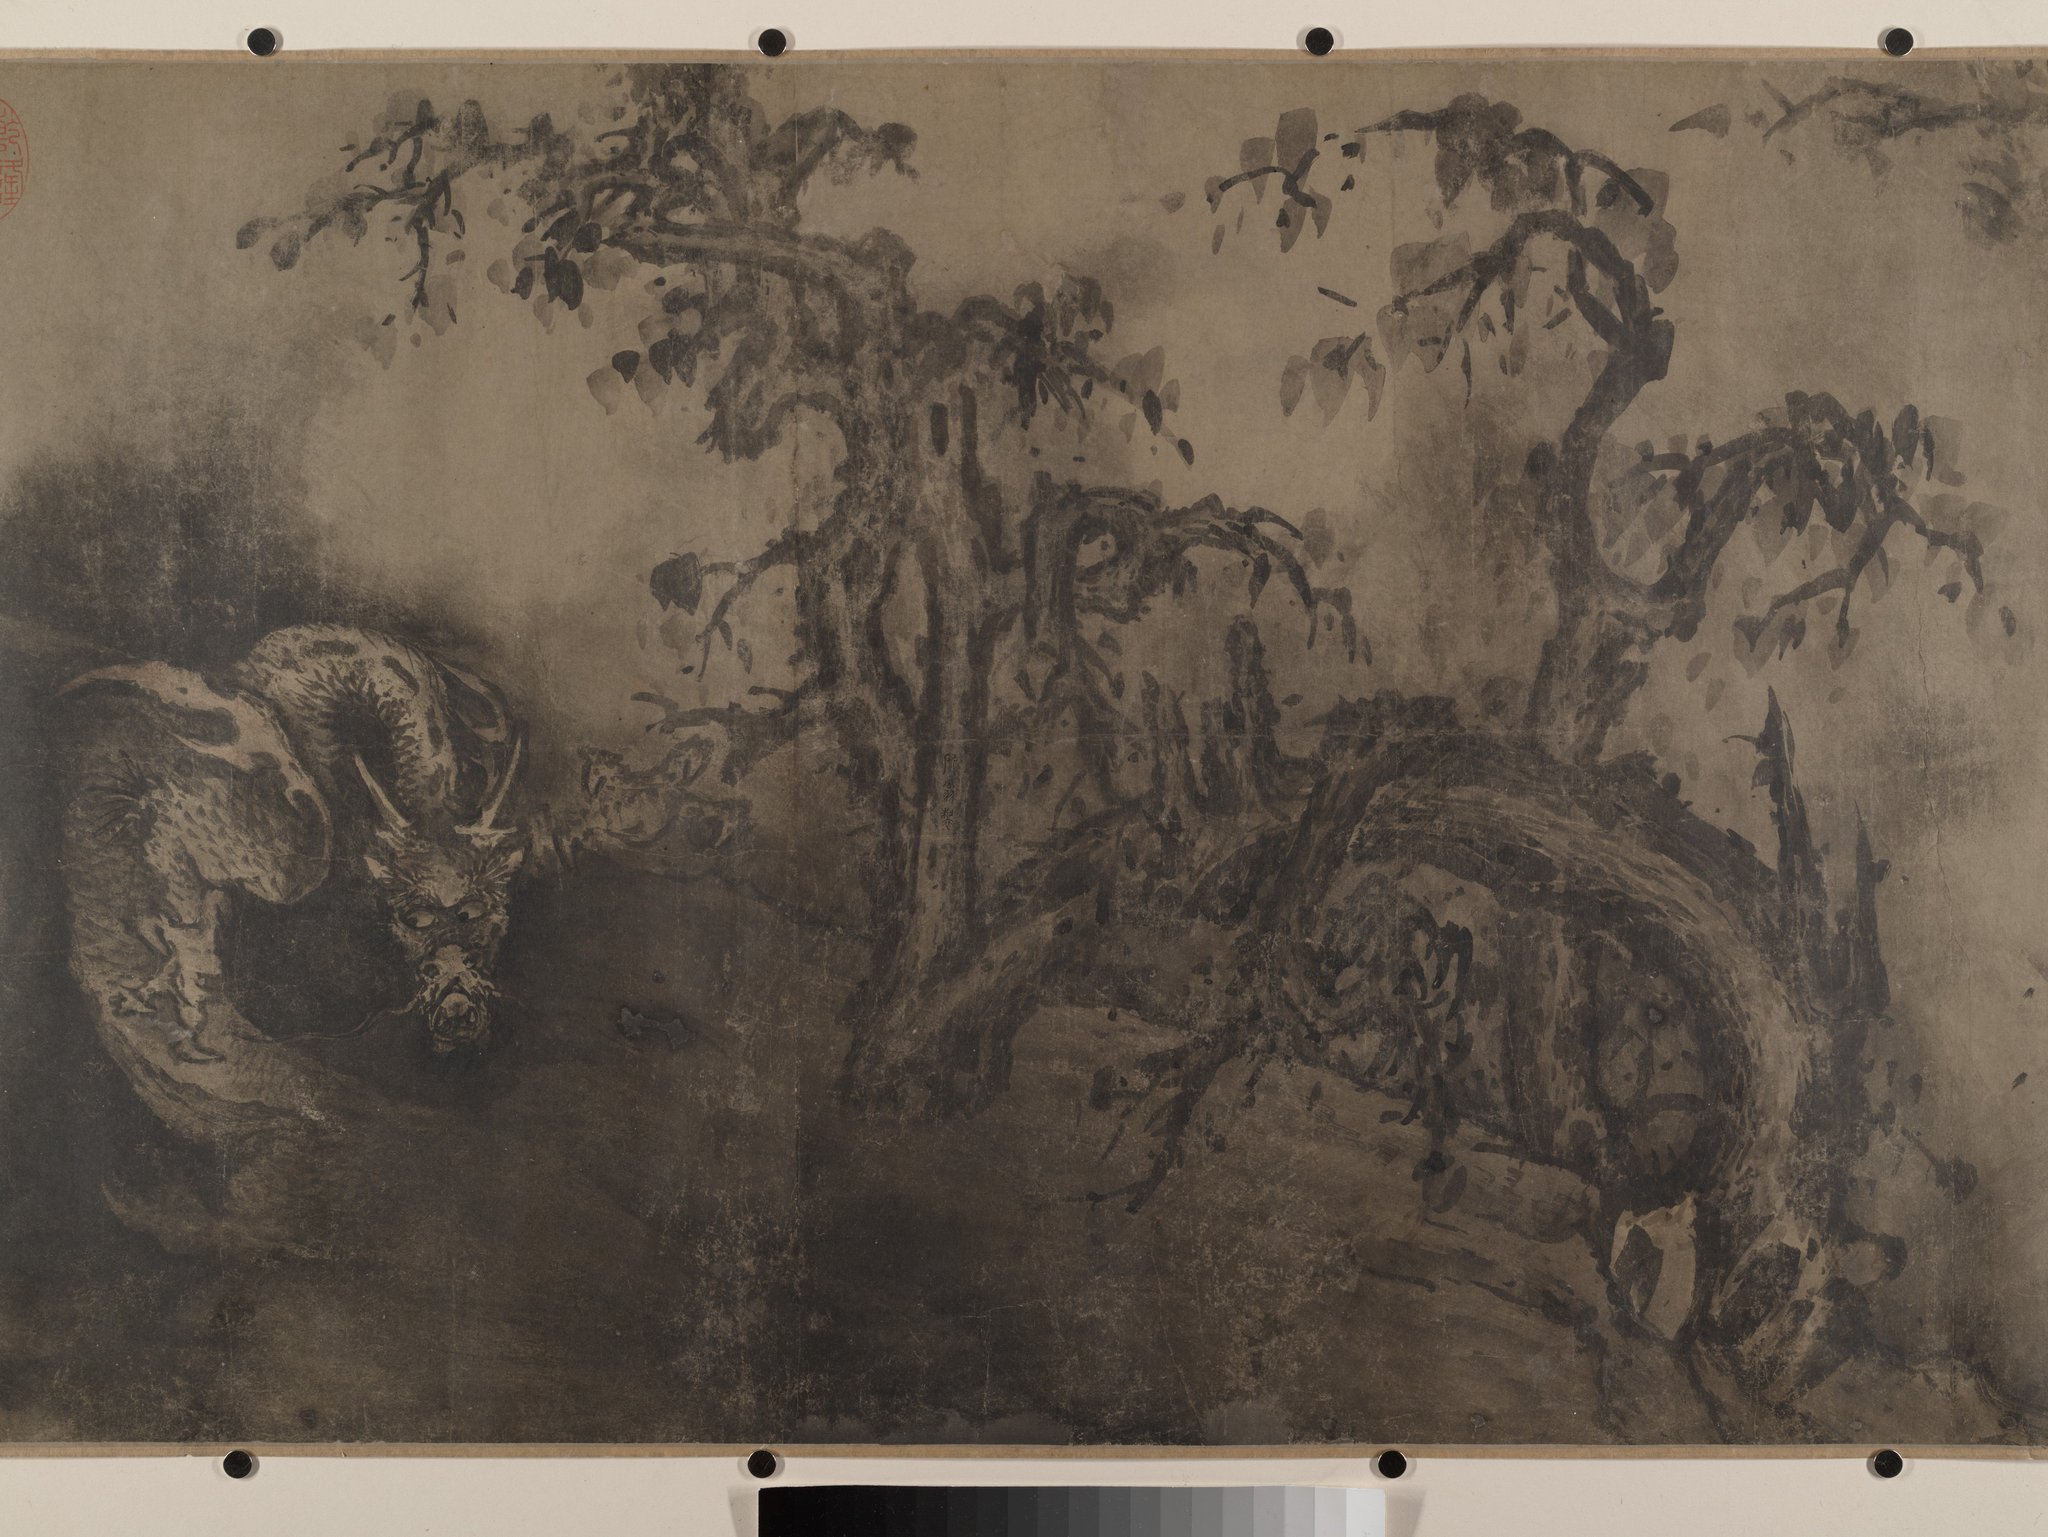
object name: handscroll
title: Dragon and Landscape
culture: chinese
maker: unidentified artist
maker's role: artist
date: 1301-1400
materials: ink, paper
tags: dragons,trees